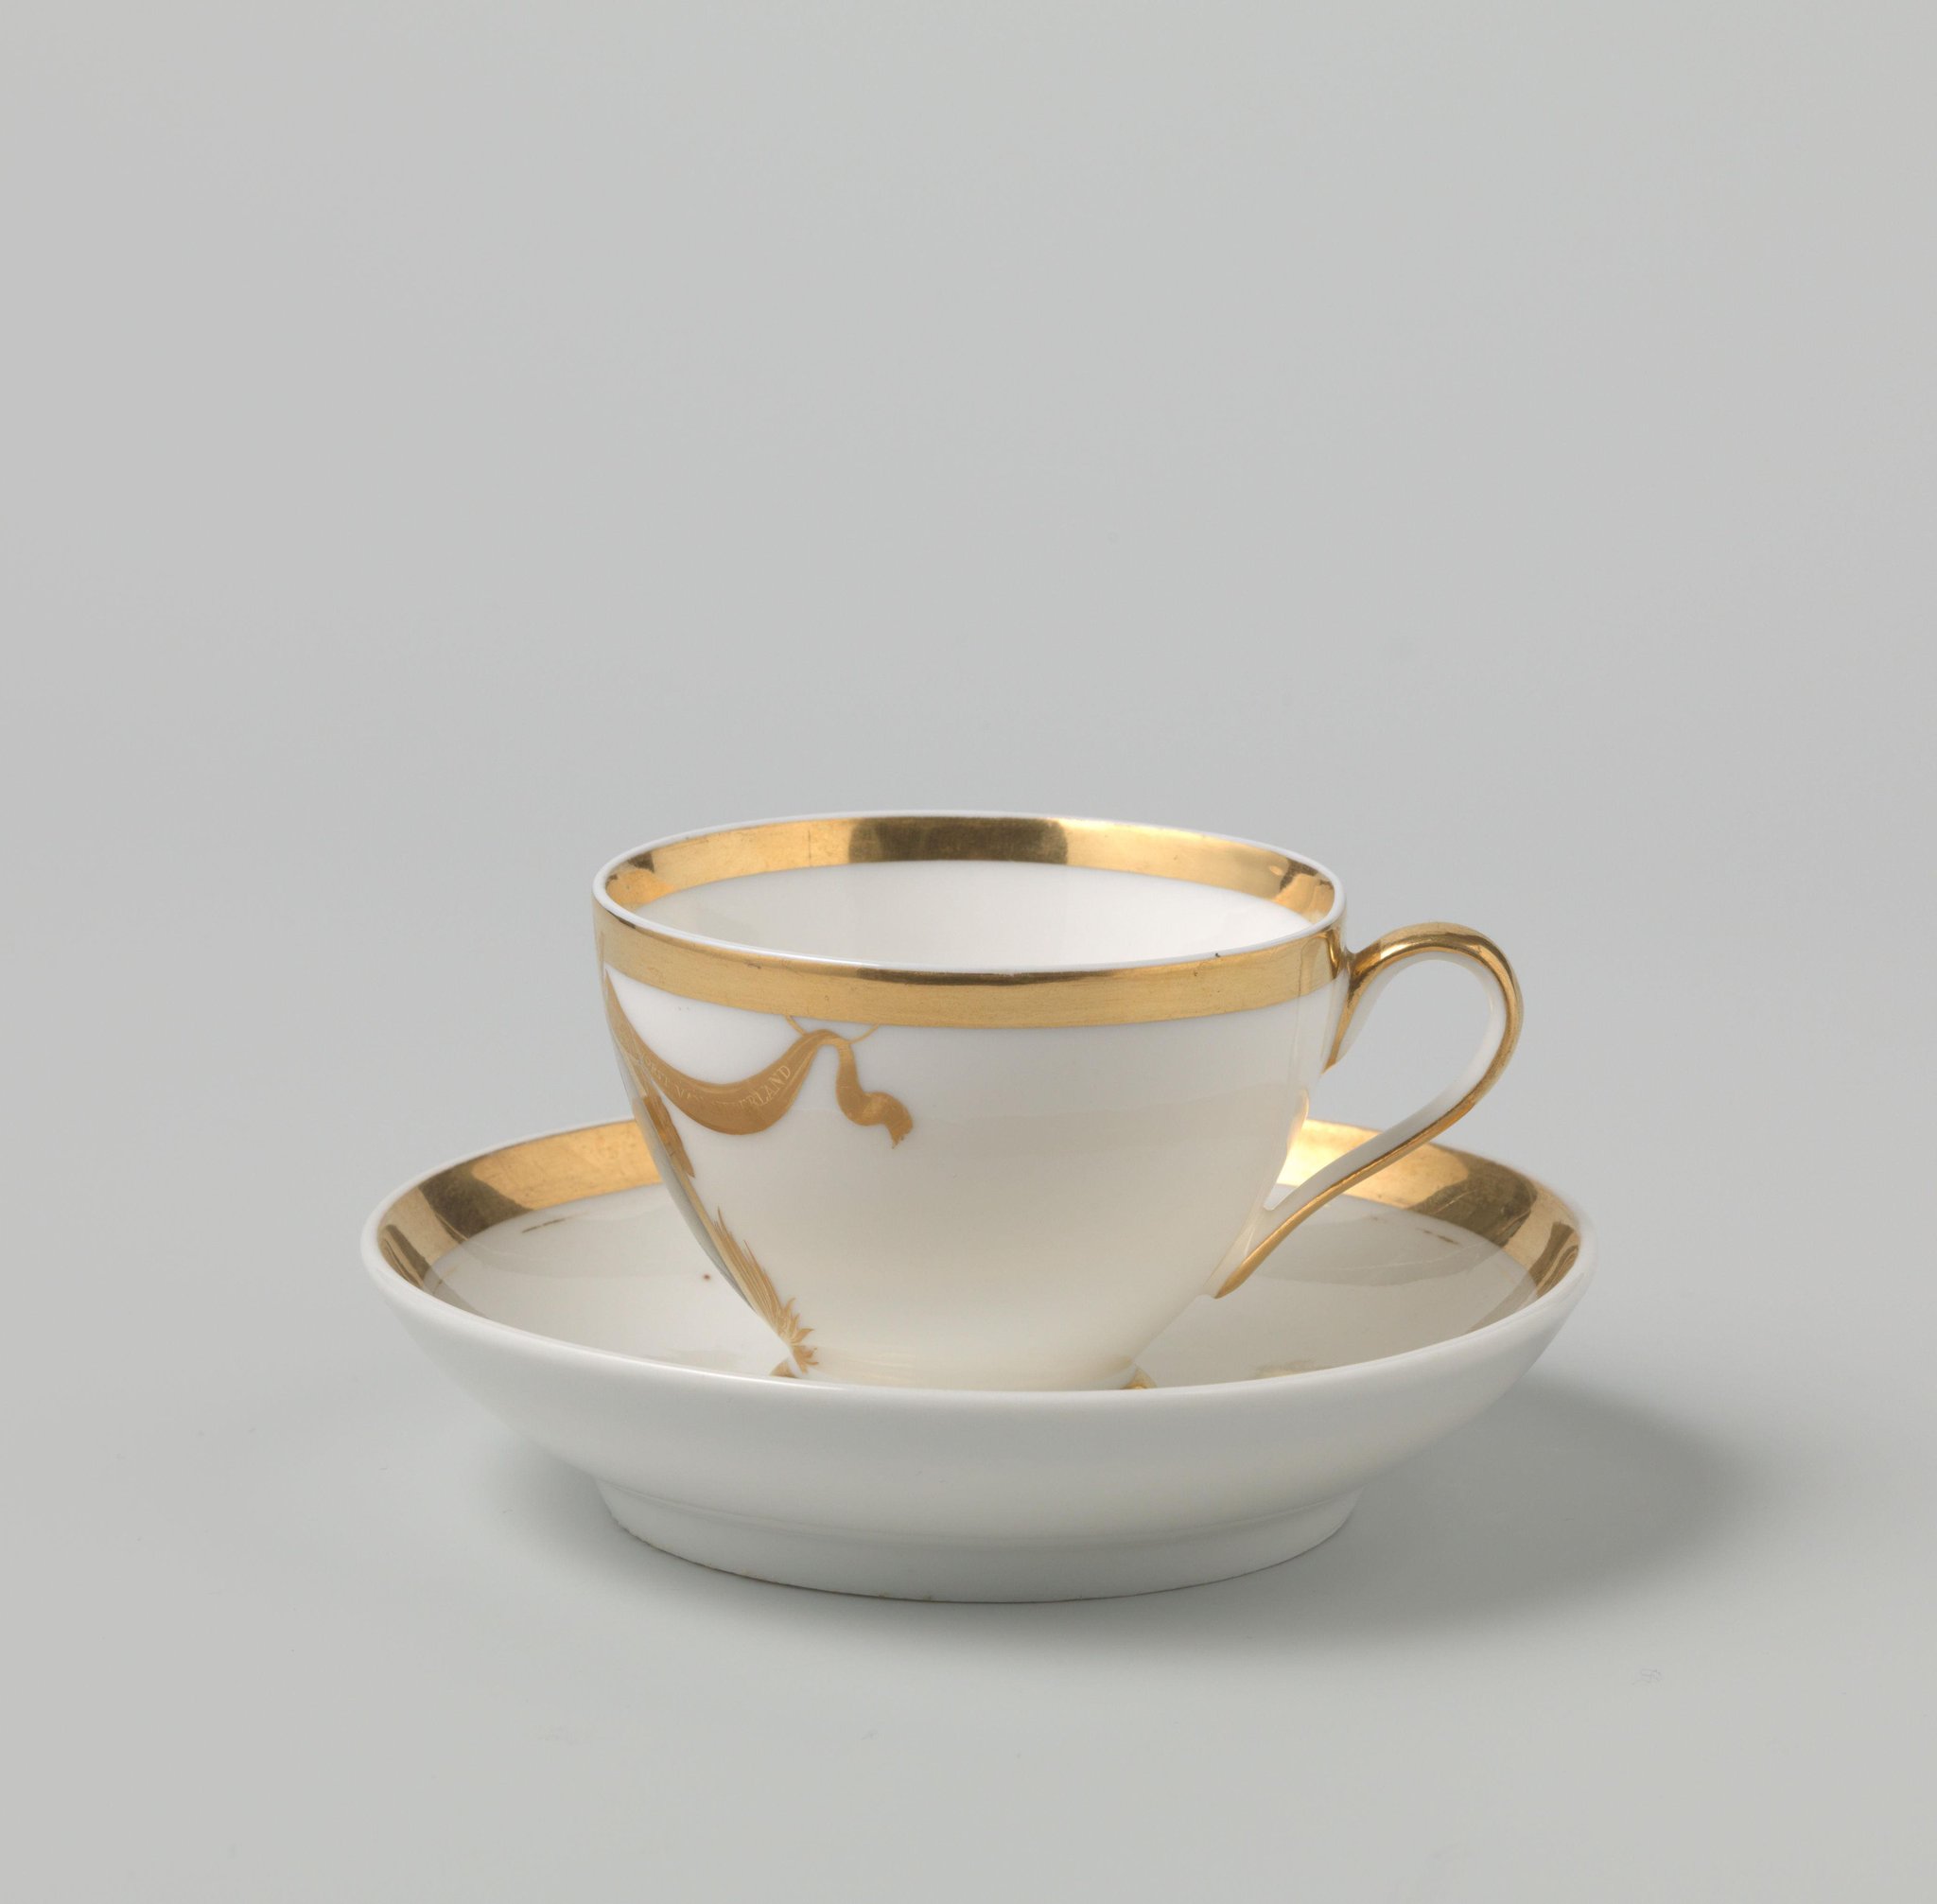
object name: cup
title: Cup with King William I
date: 1808-1815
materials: glaze, gold, paint, porcelain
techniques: firing, forming, gilding, turning, vitrification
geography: amsterdam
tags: the hague, berlin, william i of the netherlands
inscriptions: inscription: ‘A BIK A AMSTERDAM’, inscription: ‘WILLEM DE EERSTE SOUVEREIN/ VORST VAN NEDERLAND’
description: Kop van porselein met een C-vormig oor, beschilderd op het glazuur in emailkleuren en goud. Op de buitenwand van de kop een gekroond medaillon met het portret van Koning Willem I. Aan weerszijden van de kroon het wapen van Oranje en het Nederlandse staatswapen. Hiernaast een gouden lint waarin het opschrift 'WILLEM DE EERSTE SOUVEREIN/ VORST VAN NEDERLAND' is gekrast. De voet, de rand en het oor zijn bedekt met goud. Opschrift op de onderzijde met 'A BIK A AMSTERDAM'.